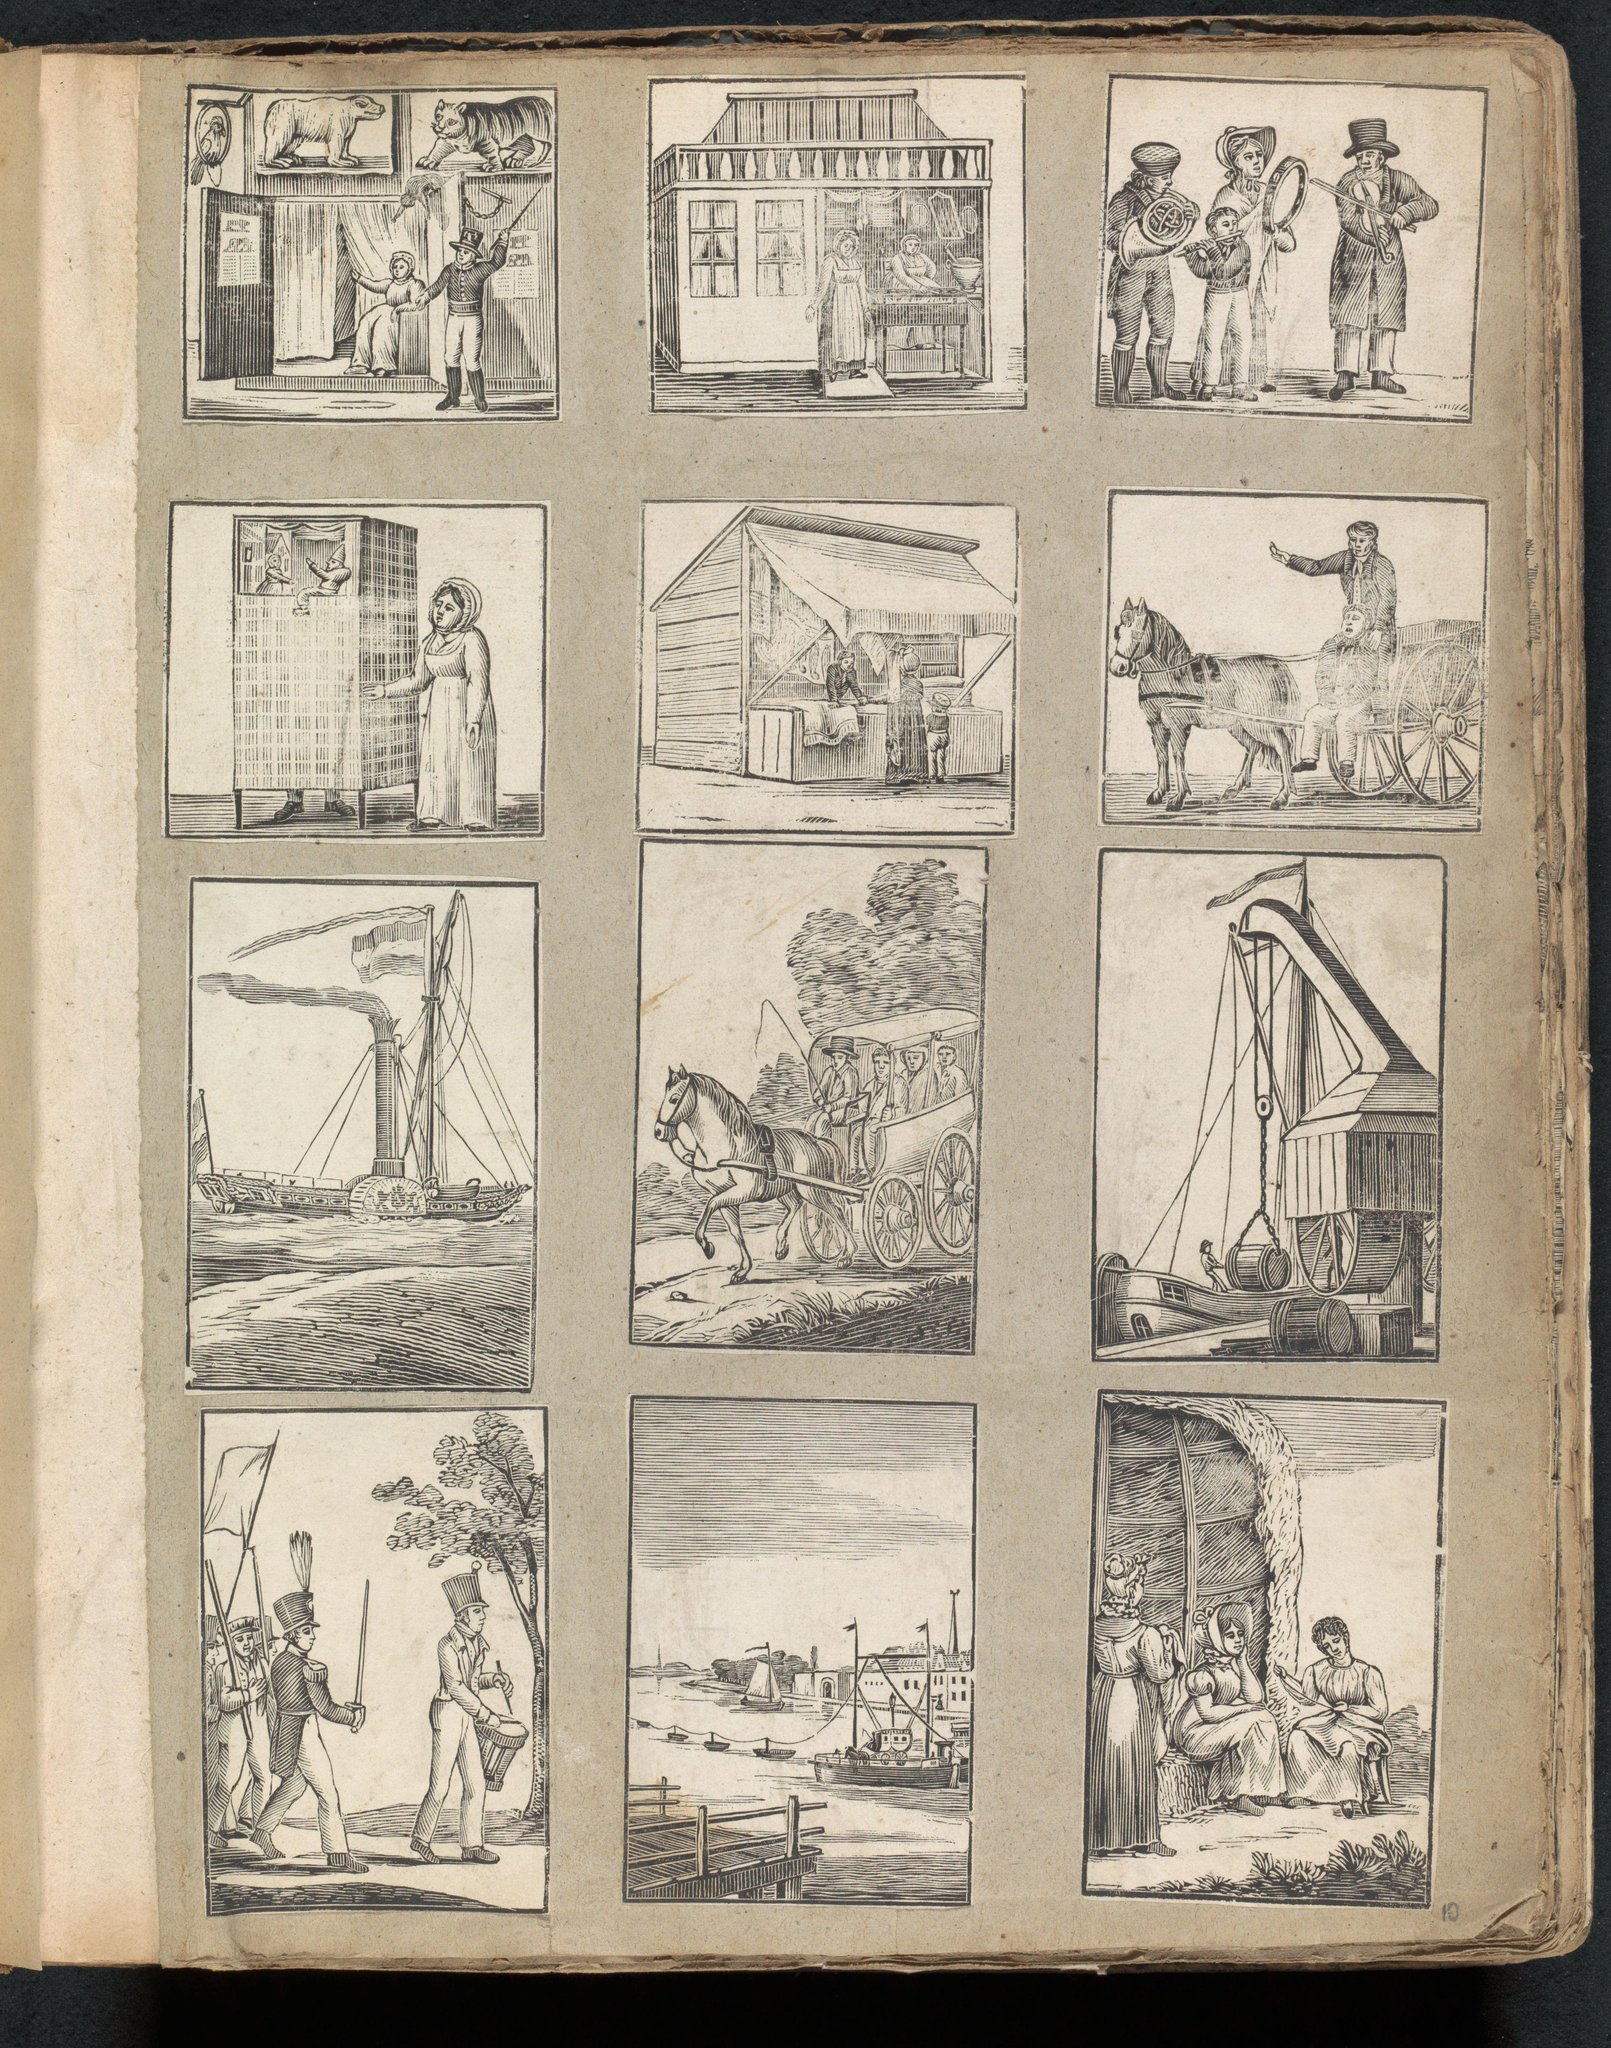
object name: popular print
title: Albumblad met diverse voorstellingen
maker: alexander cranendoncq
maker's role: draughtsman, print maker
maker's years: 1799-1869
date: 1814-1869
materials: paper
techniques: snipping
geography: nijmegen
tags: musician at work, circus animals, four-wheeled, animal-drawn vehicle, e.g.: cab, carriage, coach, ships (in general), circus, two-wheeled vehicle drawn by one animal, puppet and marionette show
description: Albumblad met 12 uitgeknipte voorstellingen uit voornamelijk volksprenten, onder andere van schepen, rijtuigen en kermistaferelen.